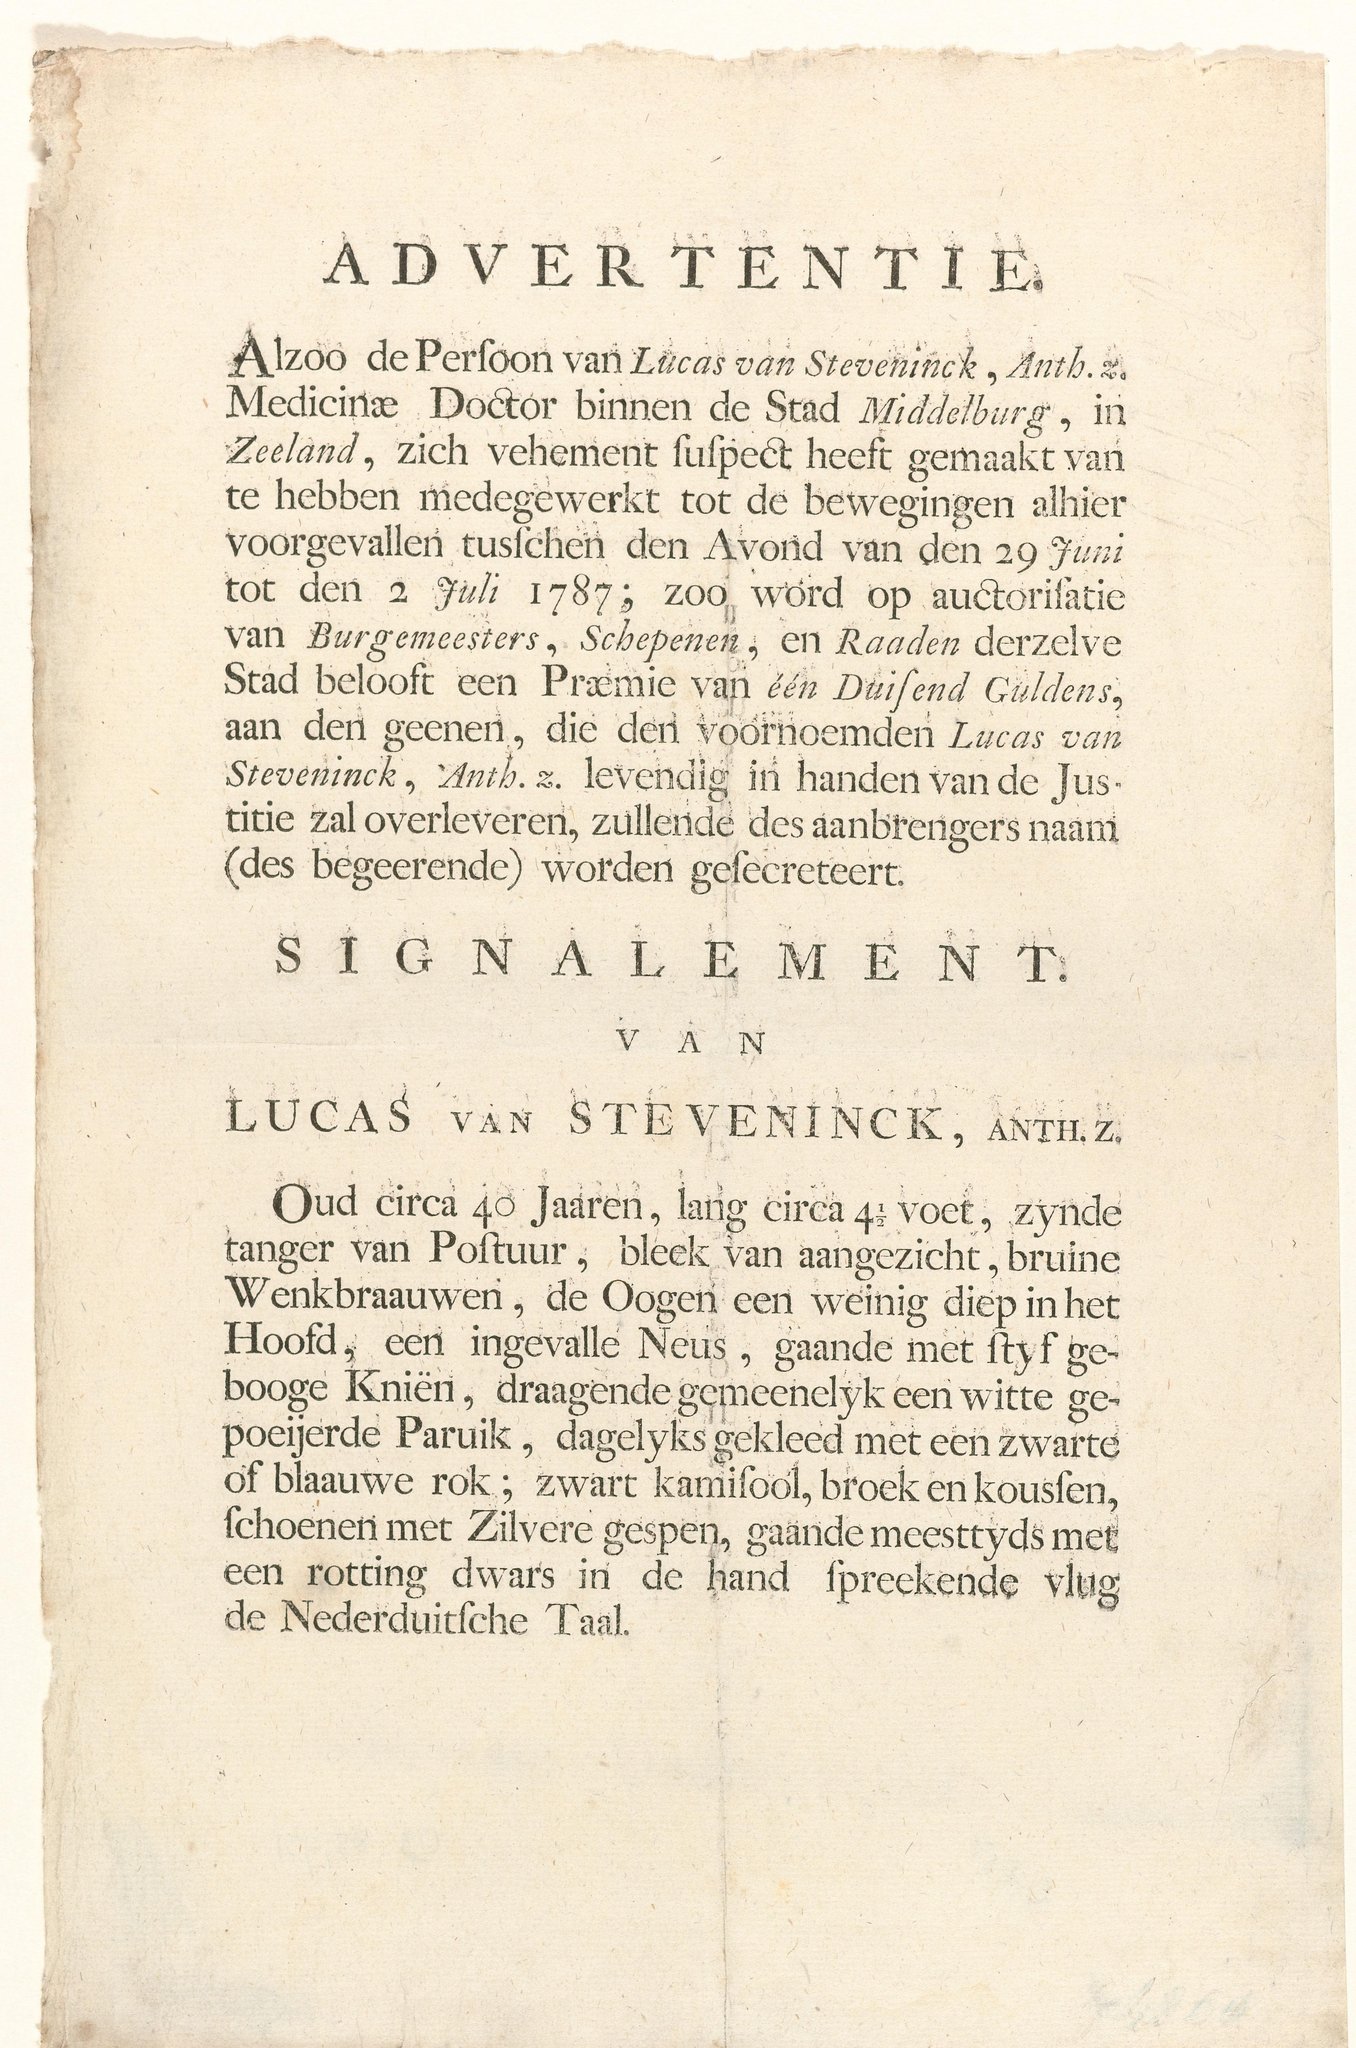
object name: text sheet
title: Signalement van Lucas van Steveninck, 1787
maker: Anonymous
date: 1787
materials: paper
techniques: letterpress printing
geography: northern netherlands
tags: advertisement, notice, middelburg, patriots (1780-1795)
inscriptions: collector's mark: Lugt 2228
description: Tekstblad "Advertentie" met een opsporingsbericht en de bekendmaking van de beloning van duizend guldens voor de aanhouding van de arts Lucas van Steveninck, naar aanleiding van de voorvallen te Middelburg tussen 29 juni en 2 juli 1787.